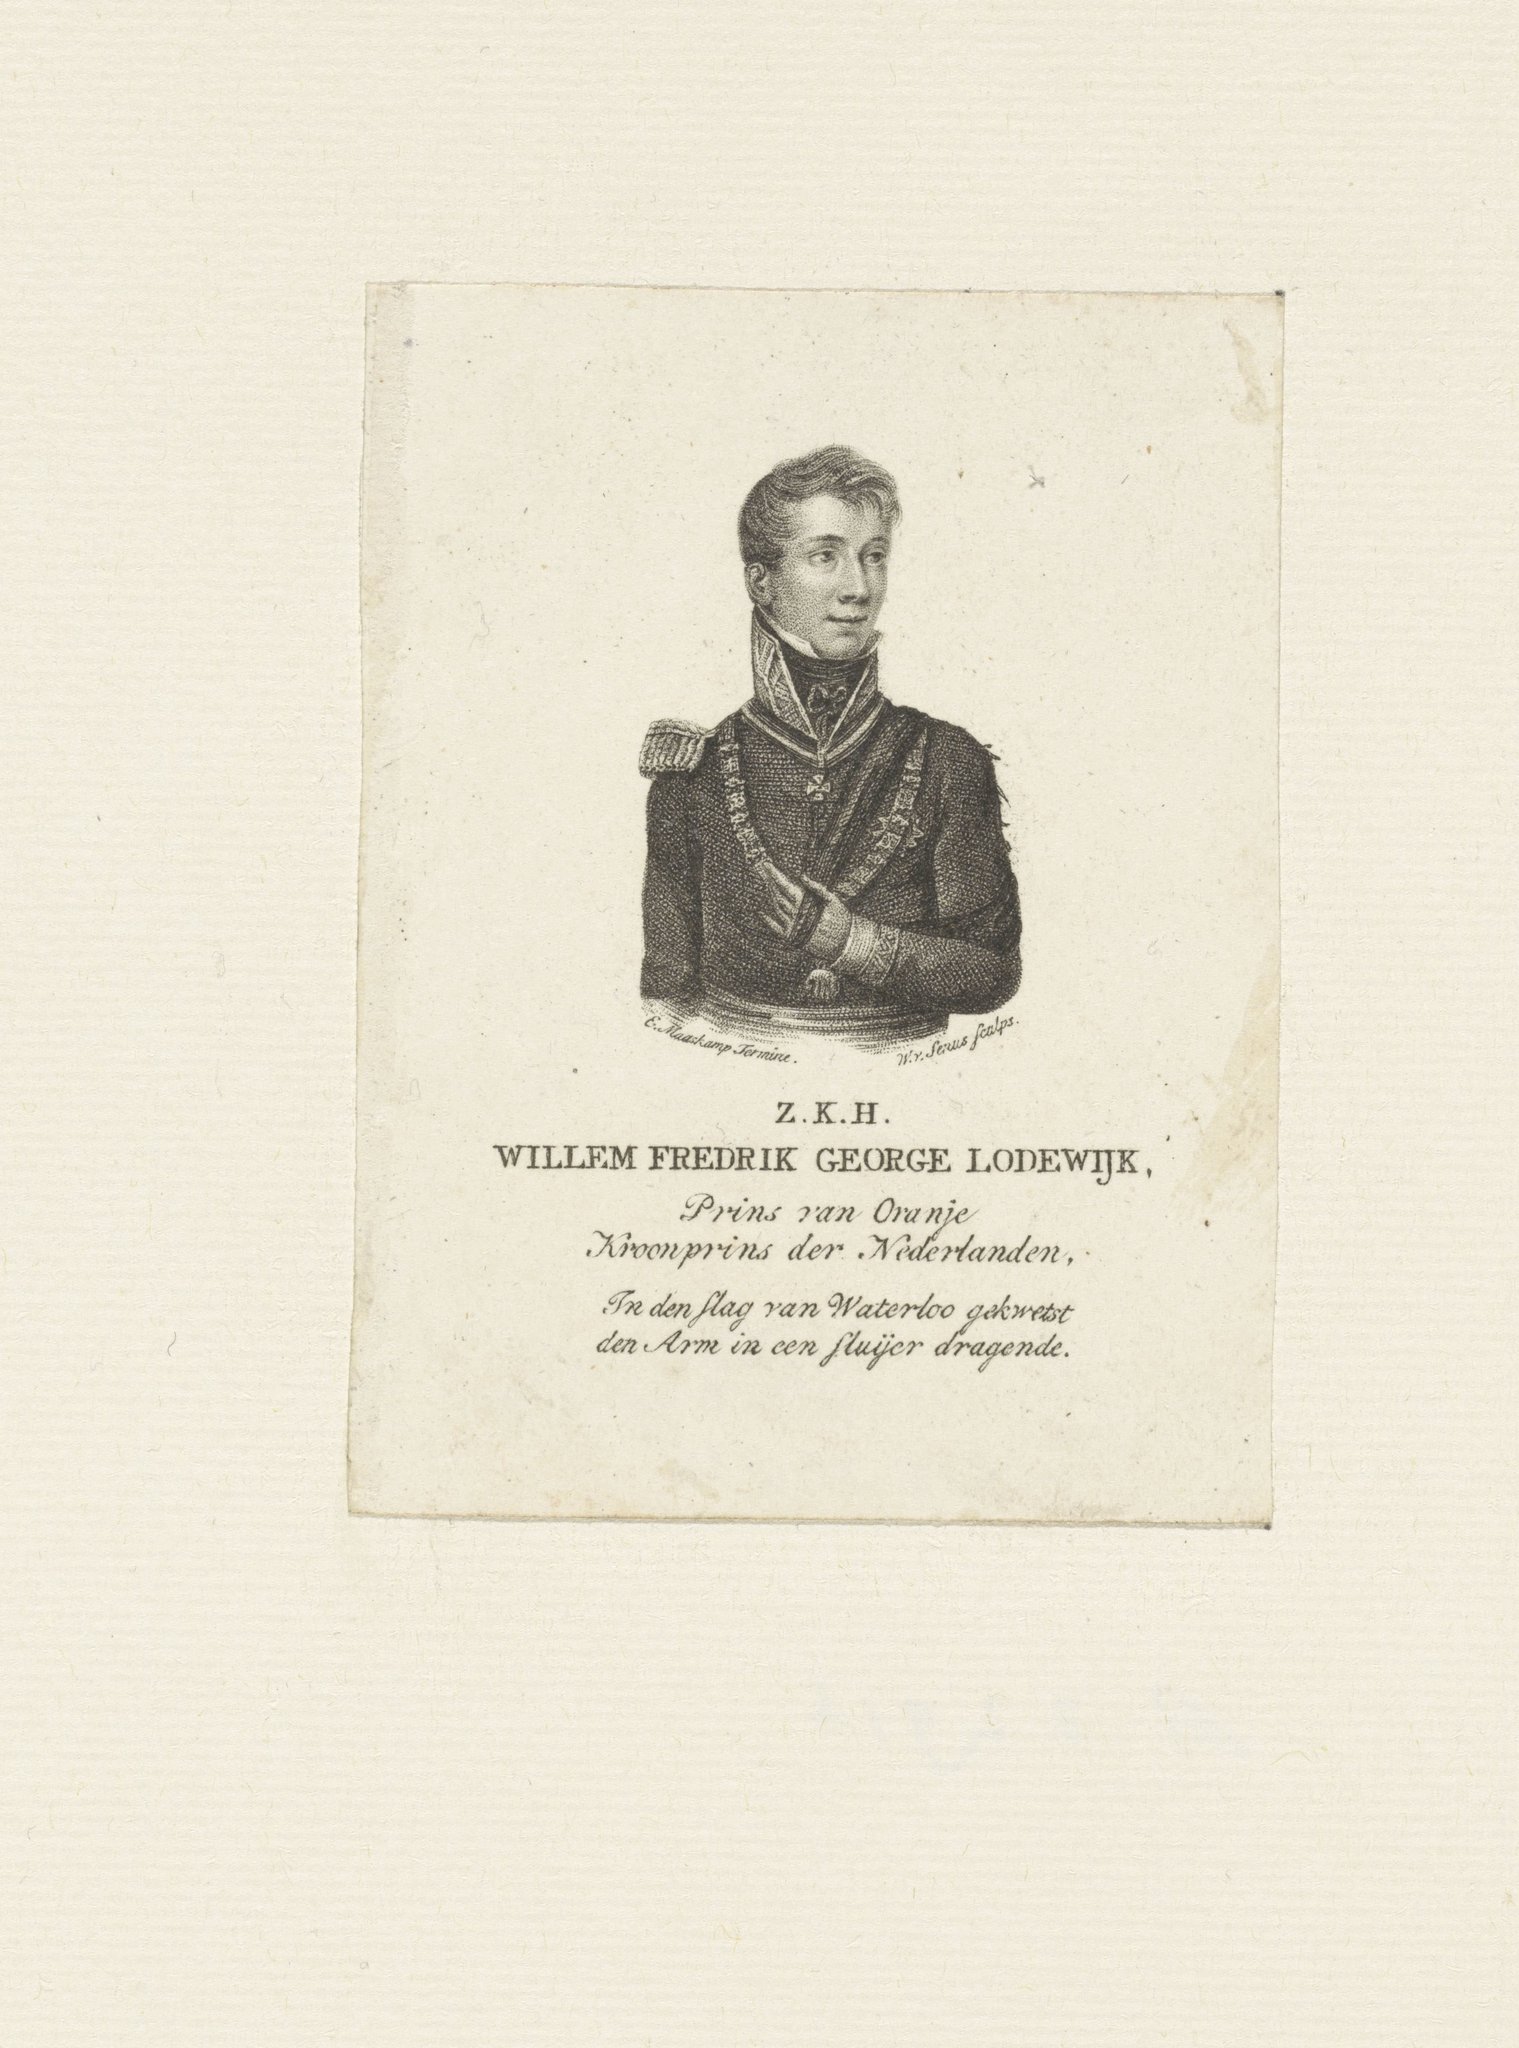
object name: print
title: Portret van Willem II, koning der Nederlanden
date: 1815-1834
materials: paper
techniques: engraving, etching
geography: amsterdam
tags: the hague, william ii of the netherlands, knighthood order of the golden fleece - insignia of a knighthood order, e.g.: badge, chain (with name of order)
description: De hier vermelde titel verwijst naar de hoogst verkregen titel van de geportretteerde, niet per se naar de titel die de geportretteerde op deze voorstelling draagt.